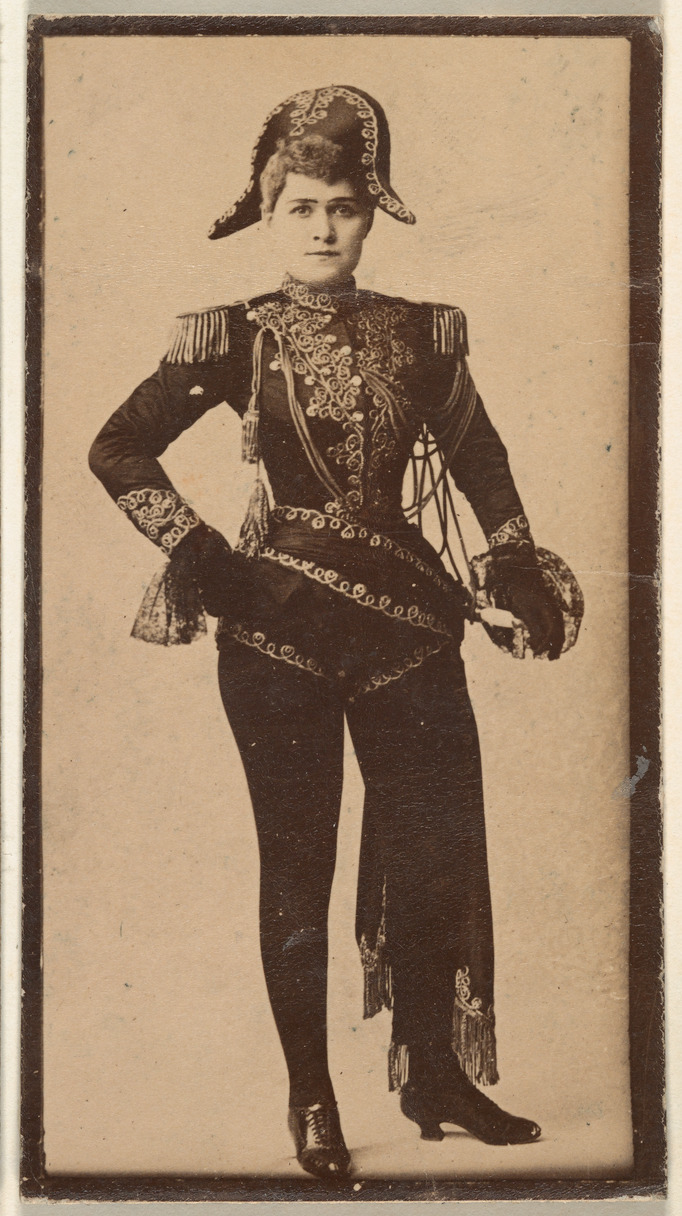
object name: photograph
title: Actress wearing military-inspired costume, from the Actresses series (N668)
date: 1888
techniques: albumen silver print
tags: portraits,women,actresses